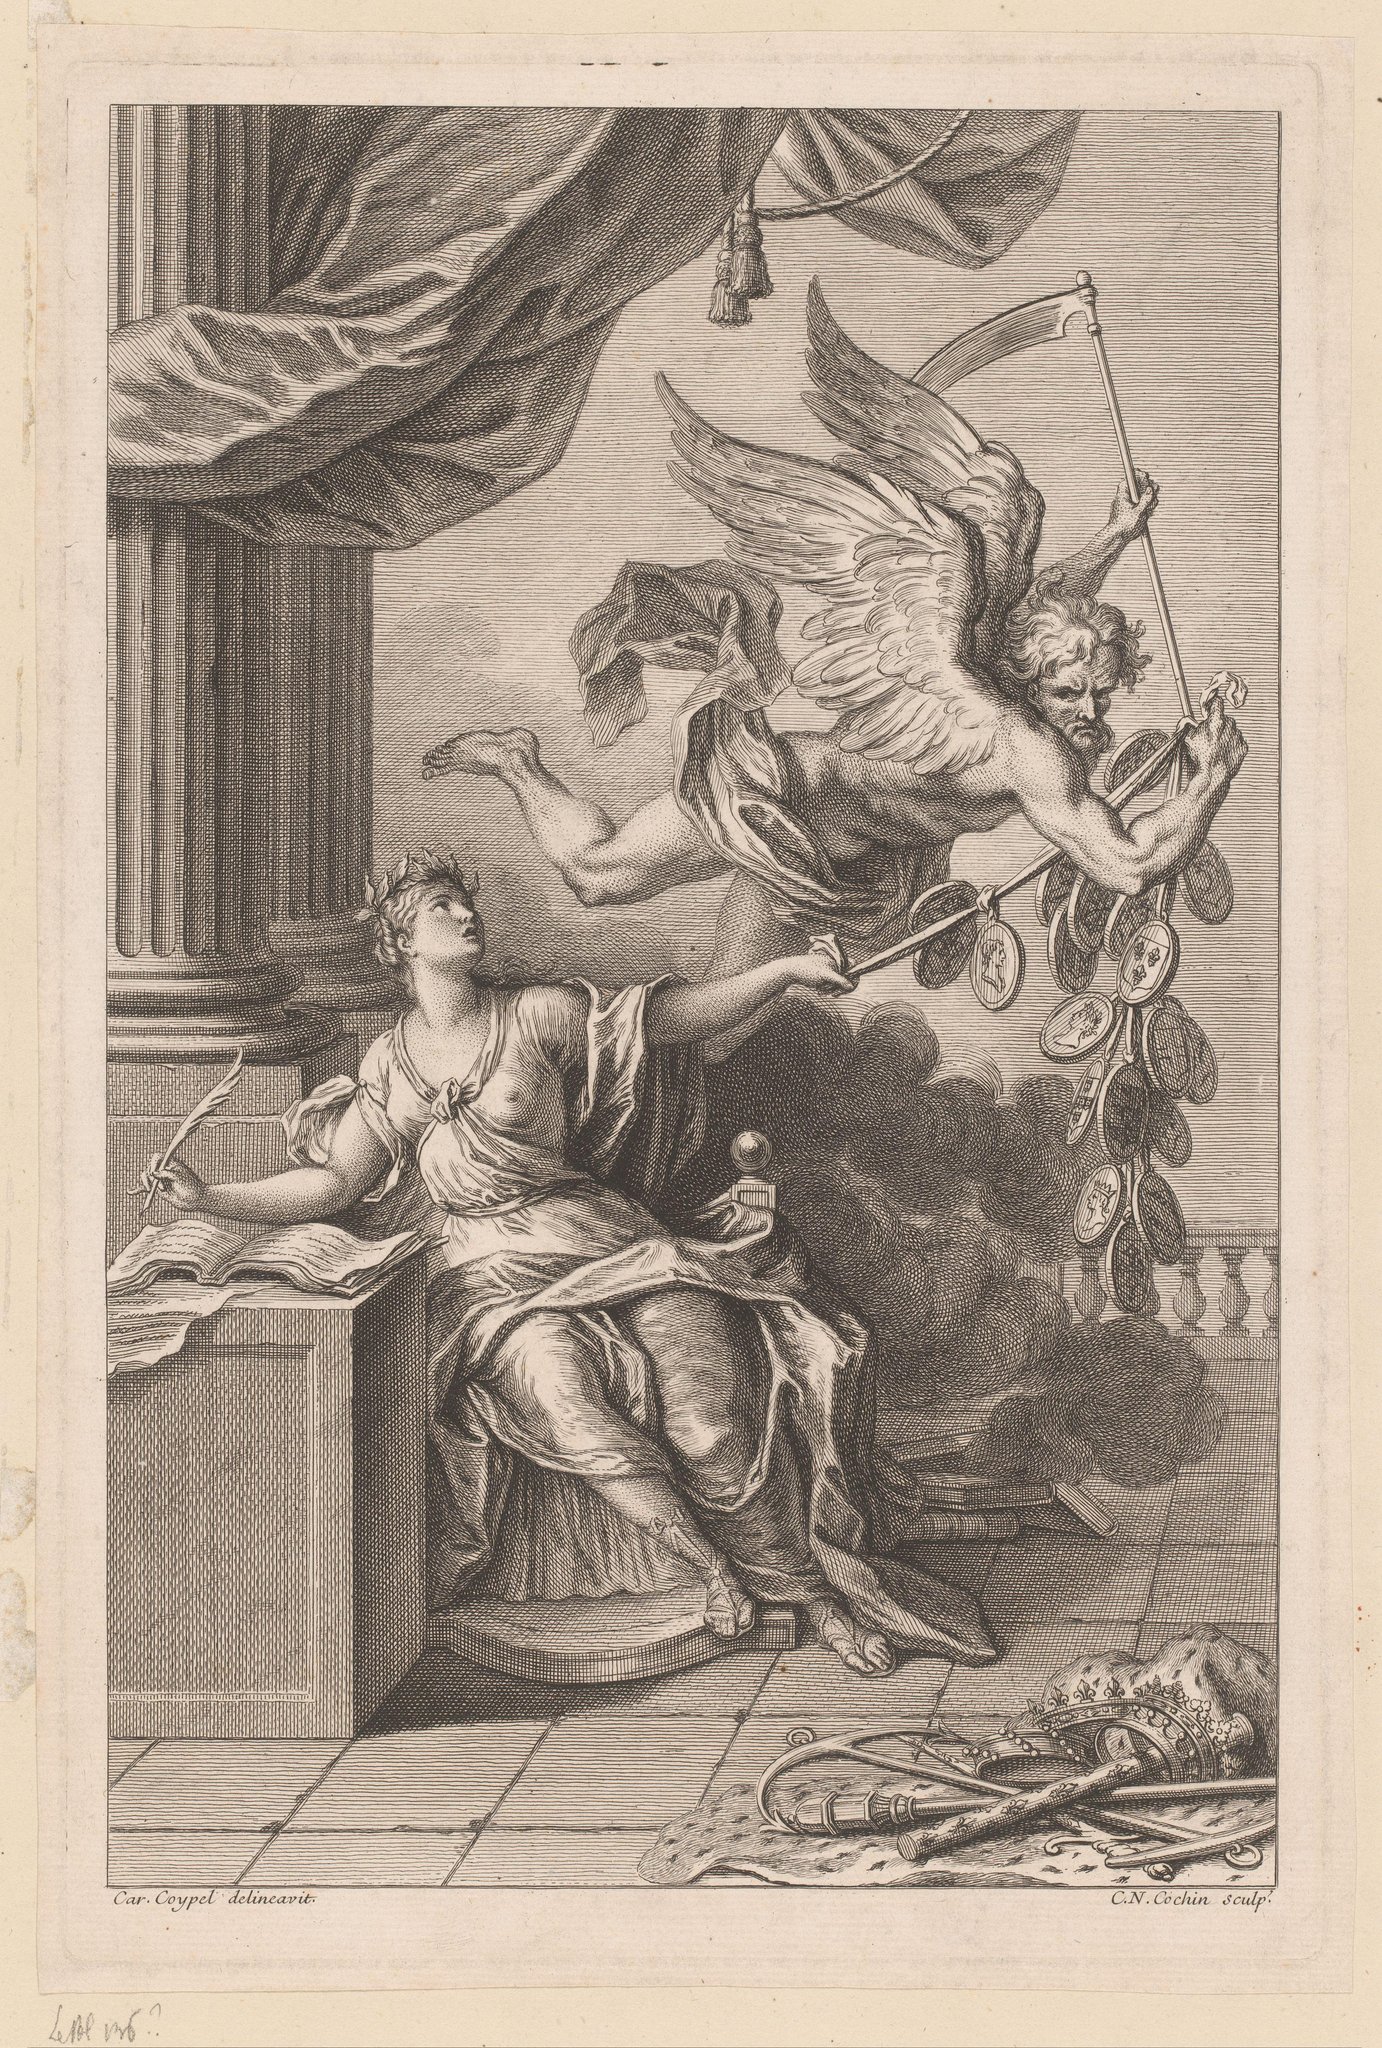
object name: print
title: Allegorisch tafereel met medaillons en de Tijd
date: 1704-1754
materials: paper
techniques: engraving, etching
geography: france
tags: writing-table, writing-desk, ornament ~ medallion, father time, man with wings and scythe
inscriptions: collector's mark: Lugt 240